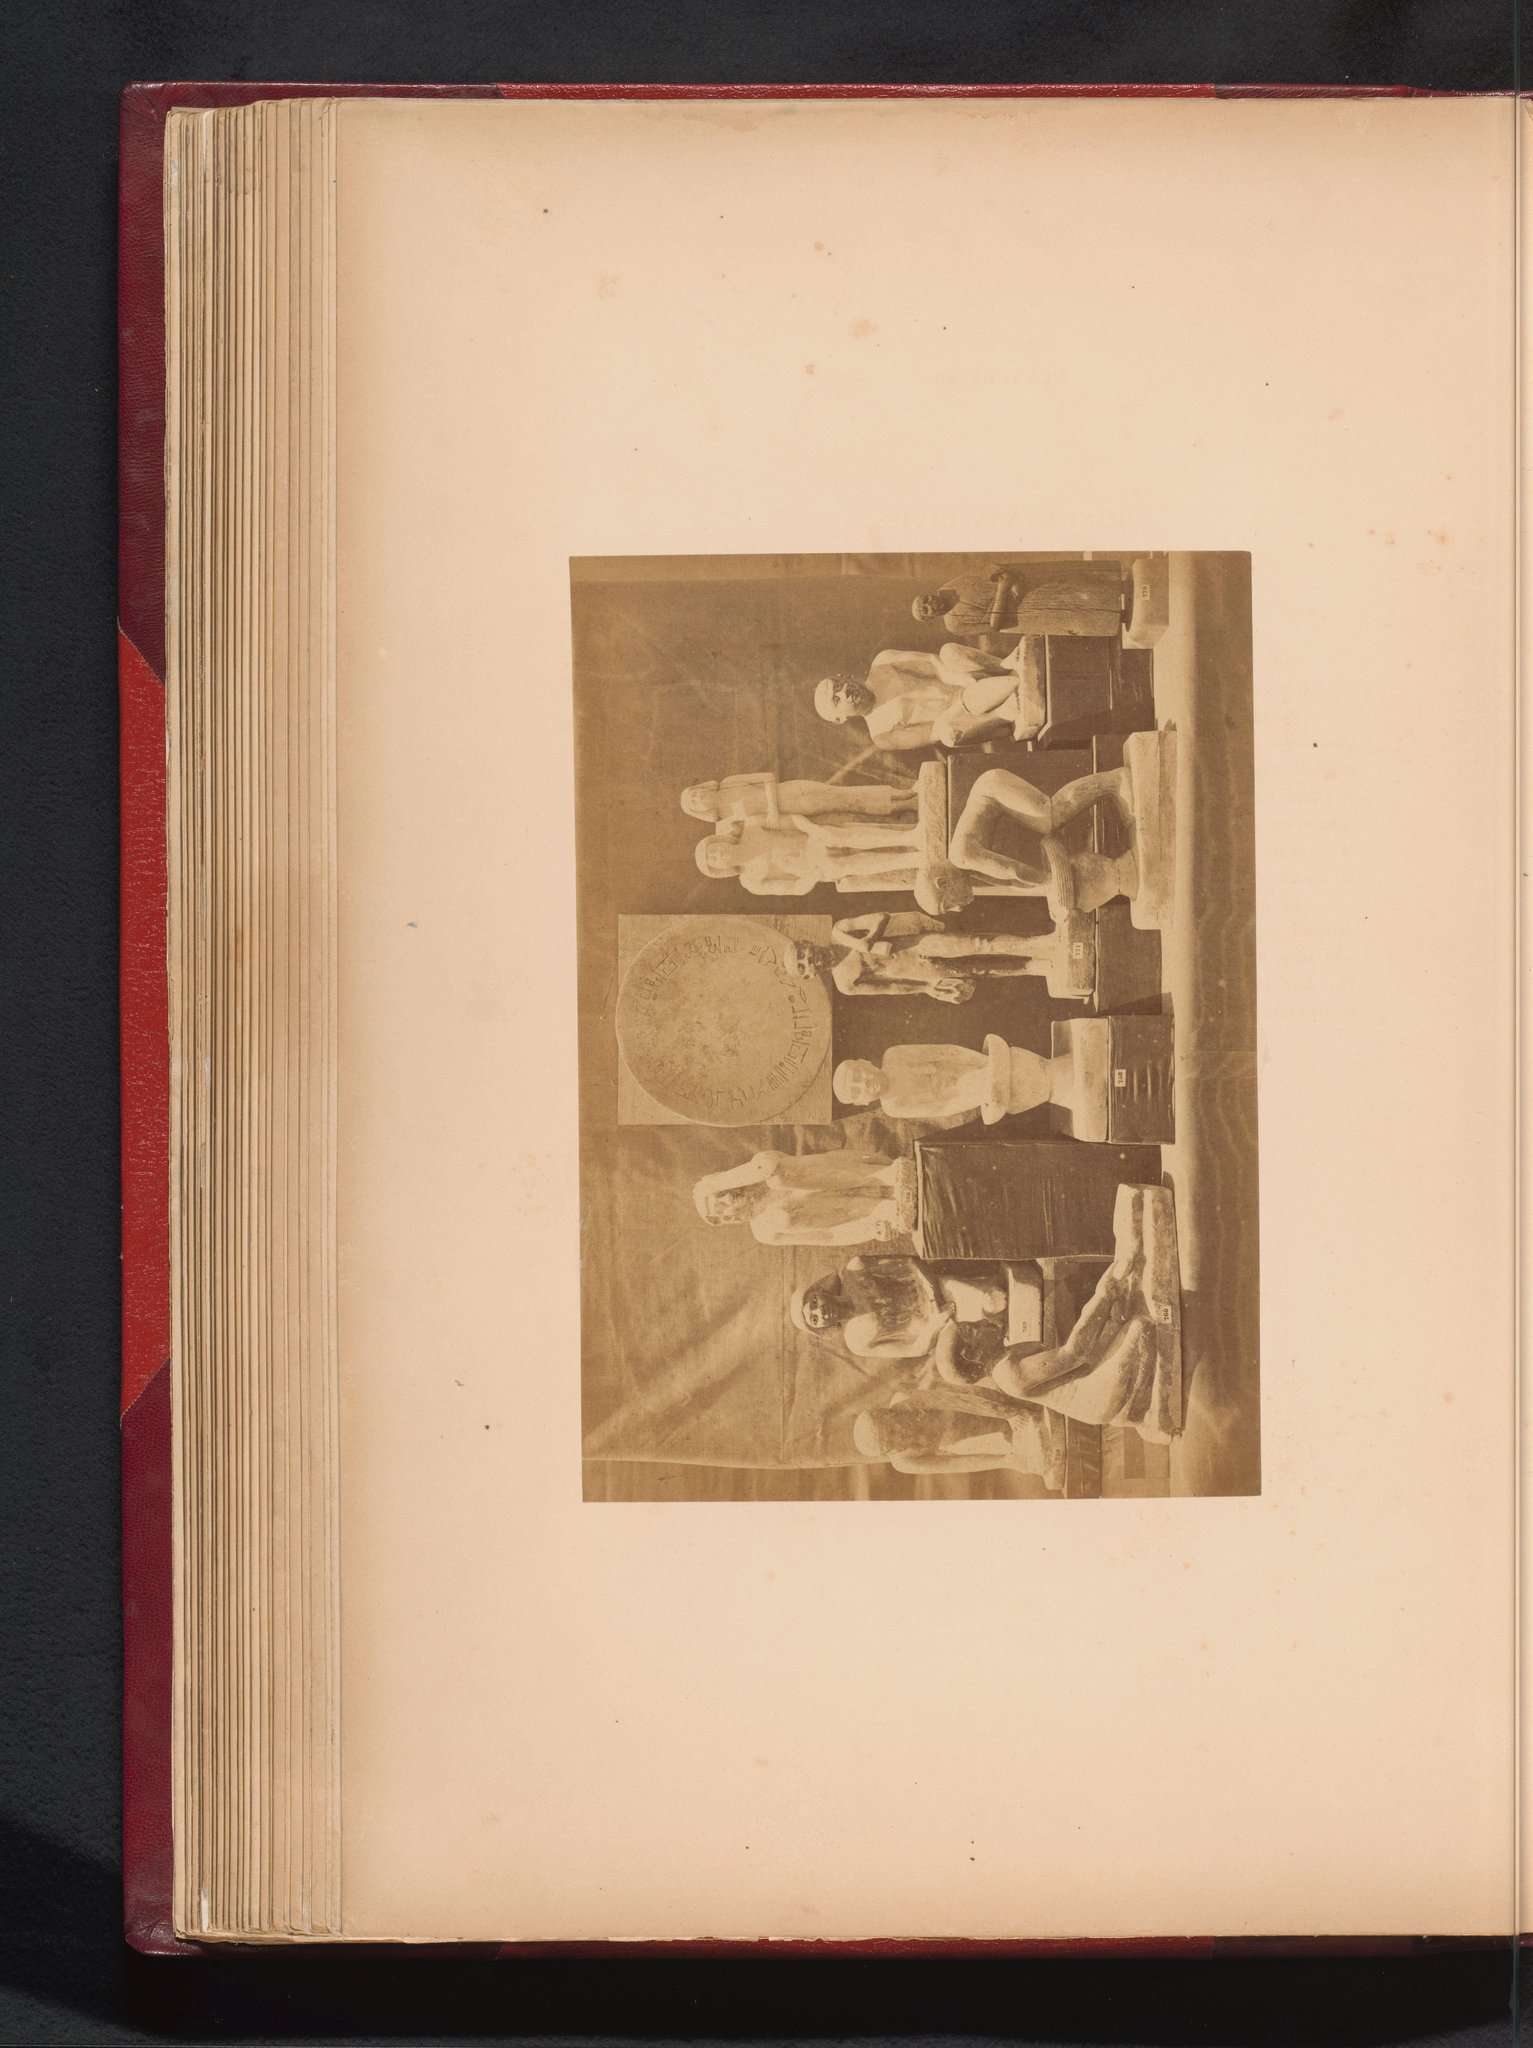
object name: photograph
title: Beelden uit Egyptische graven in het Boulaq Museum in Caïro, Egypte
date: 1866-1871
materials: photographic support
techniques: albumen print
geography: cairo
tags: signs, symbols and motifs in funerary art, permanent exhibition, museum